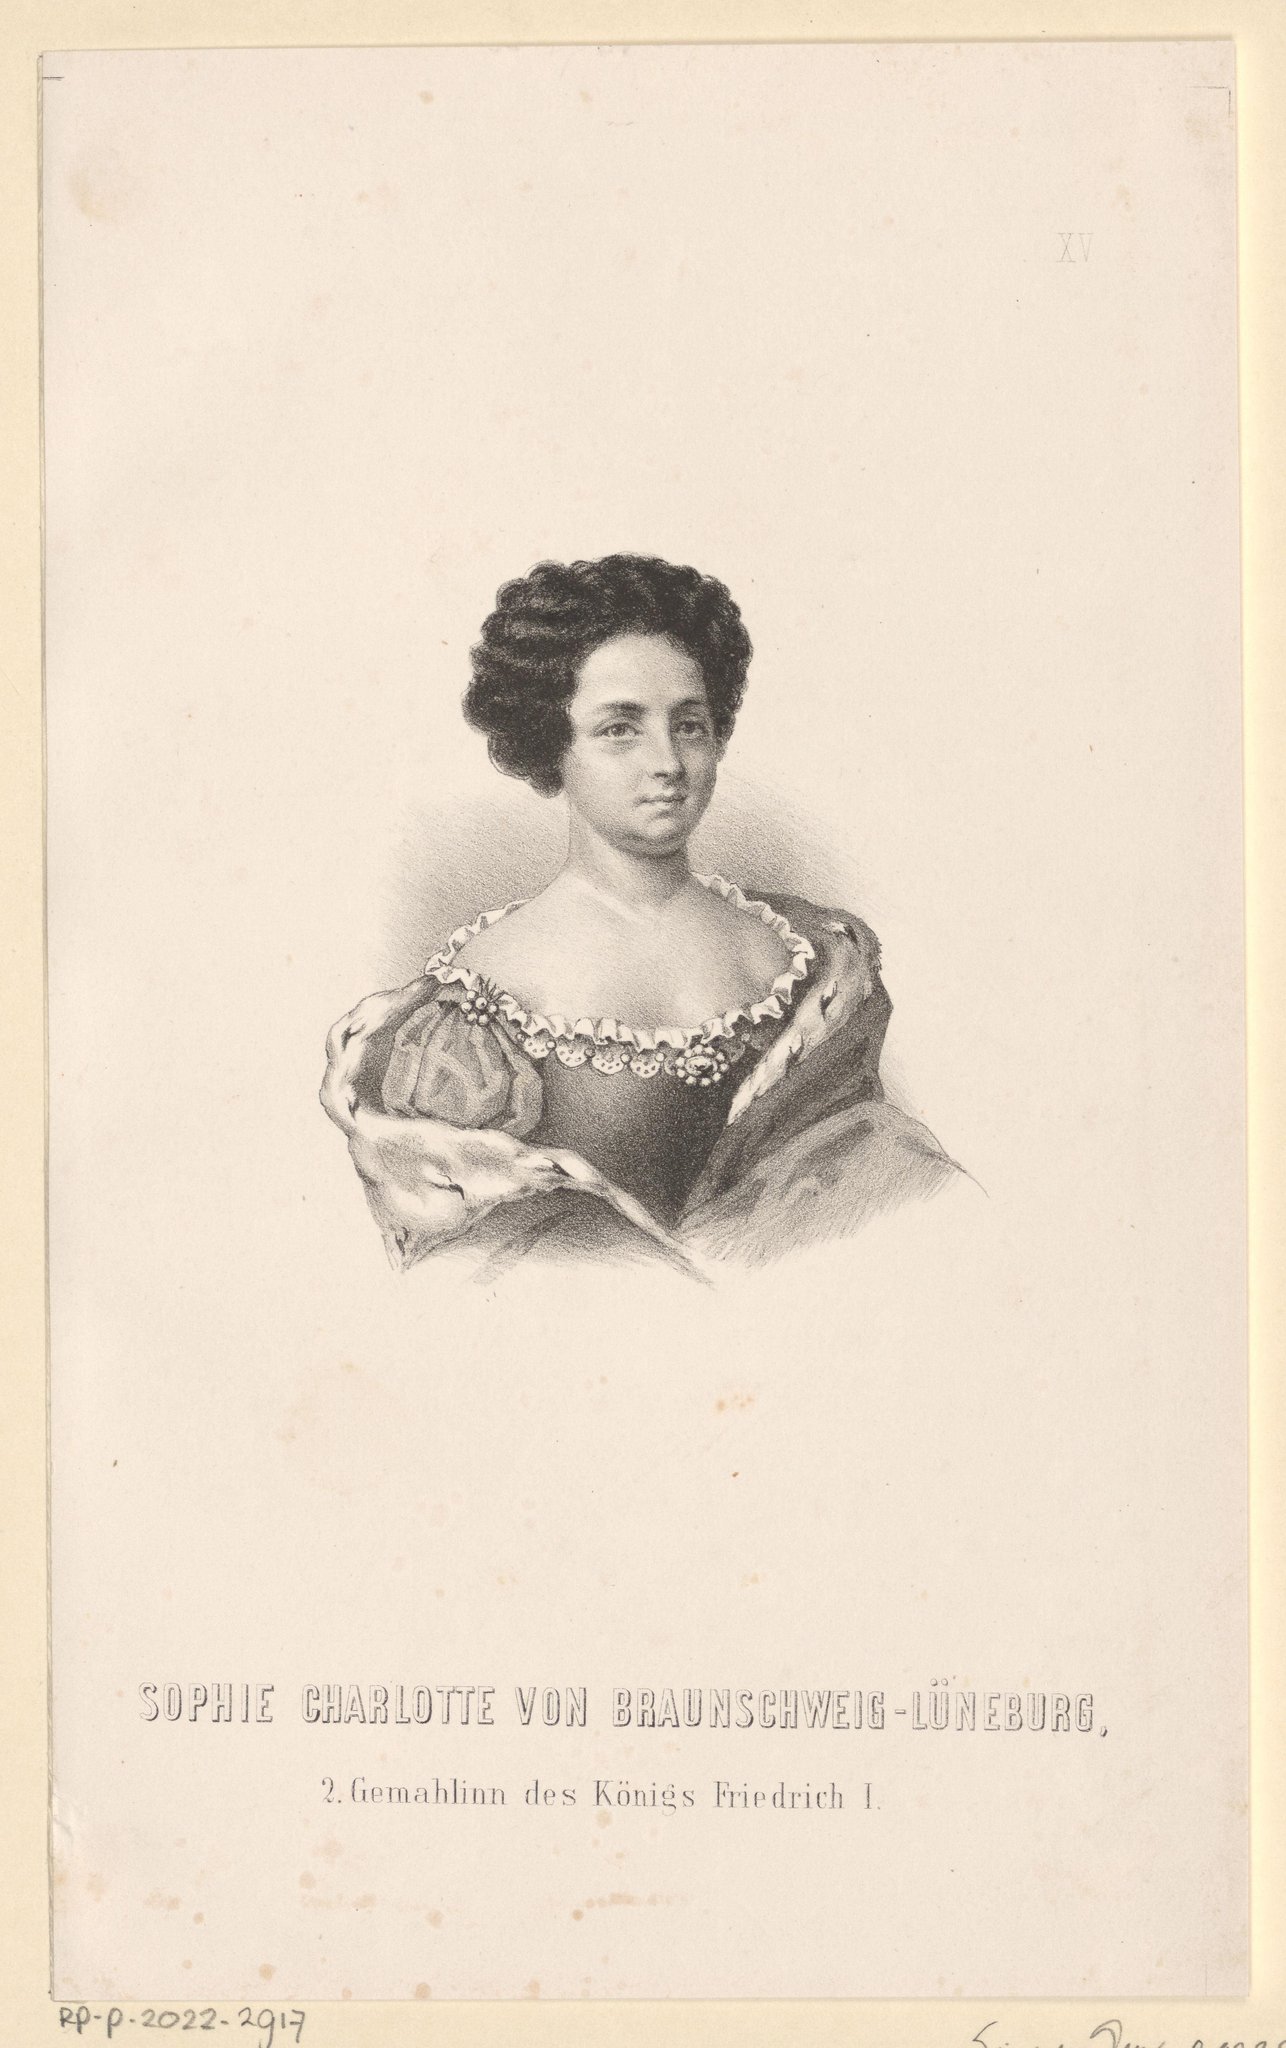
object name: print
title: Portret van Sophie Charlotte van Hannover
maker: Anonymous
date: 1798-1899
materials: paper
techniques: lithograph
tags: historical persons - bb - woman, queen, empress, etc. (wife of a ruler)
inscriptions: number: ‘No 414’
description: Met eenregelig onderschrift in het Duits.